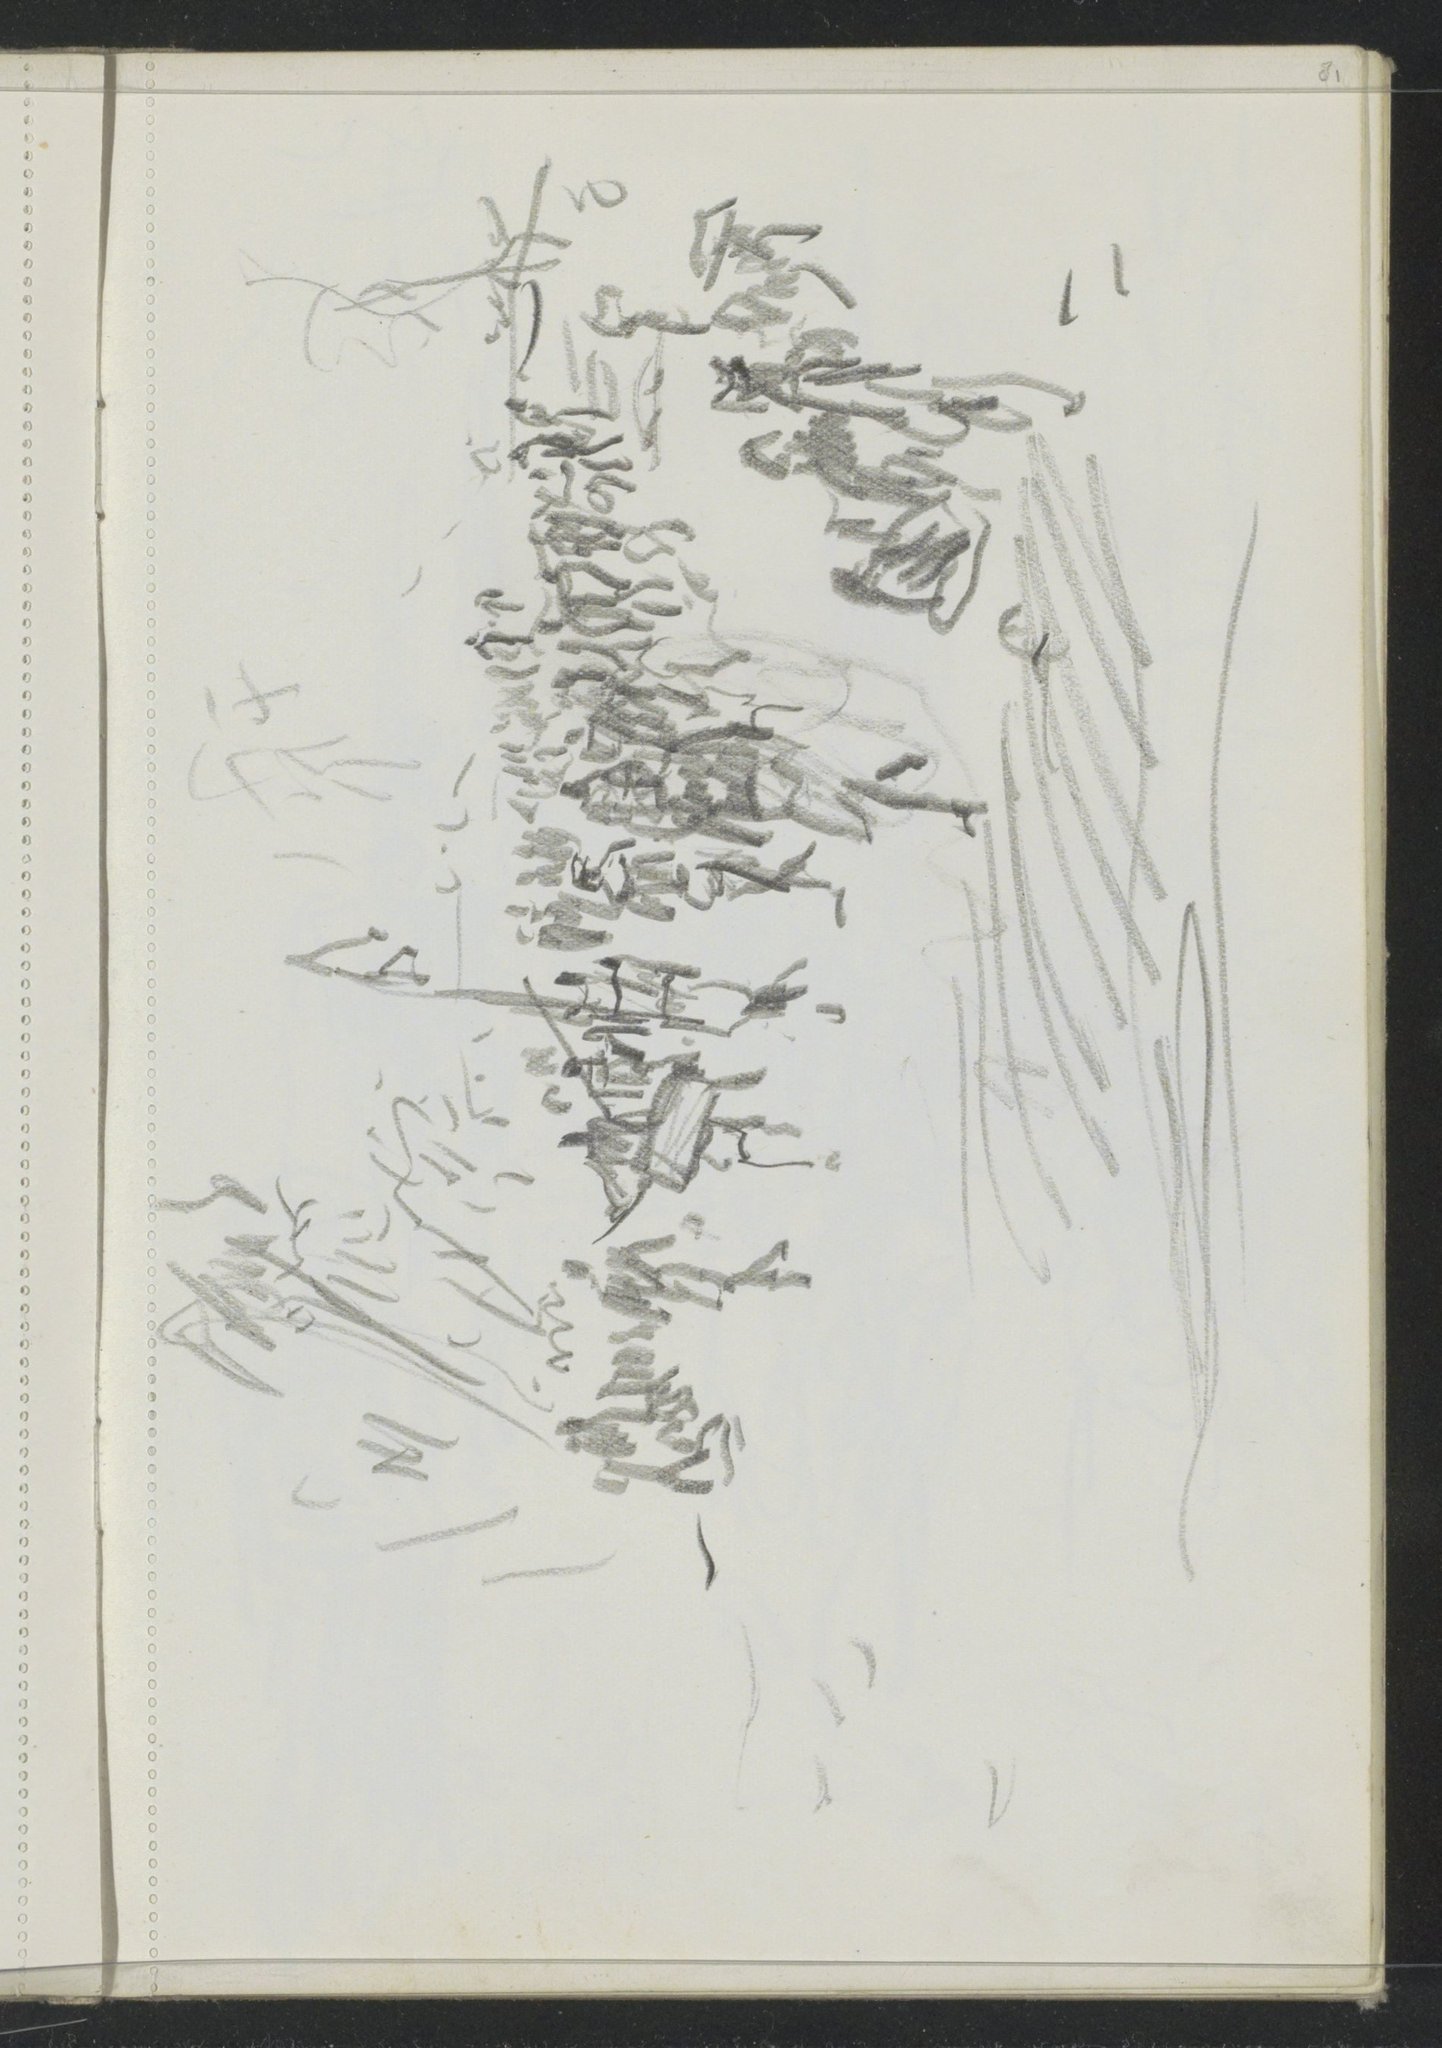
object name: sketchbook leaf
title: Optocht van figuren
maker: marius bauer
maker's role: draughtsman, print maker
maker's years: 1867-1932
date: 1925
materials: paper, pencil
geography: indonesia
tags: standard-bearer, flag-bearer, drum (musical instrument), walking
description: Op de voorgrond figuren met een vlag en een trommel. Pagina 81 uit een schetsboek met 74 bladen.